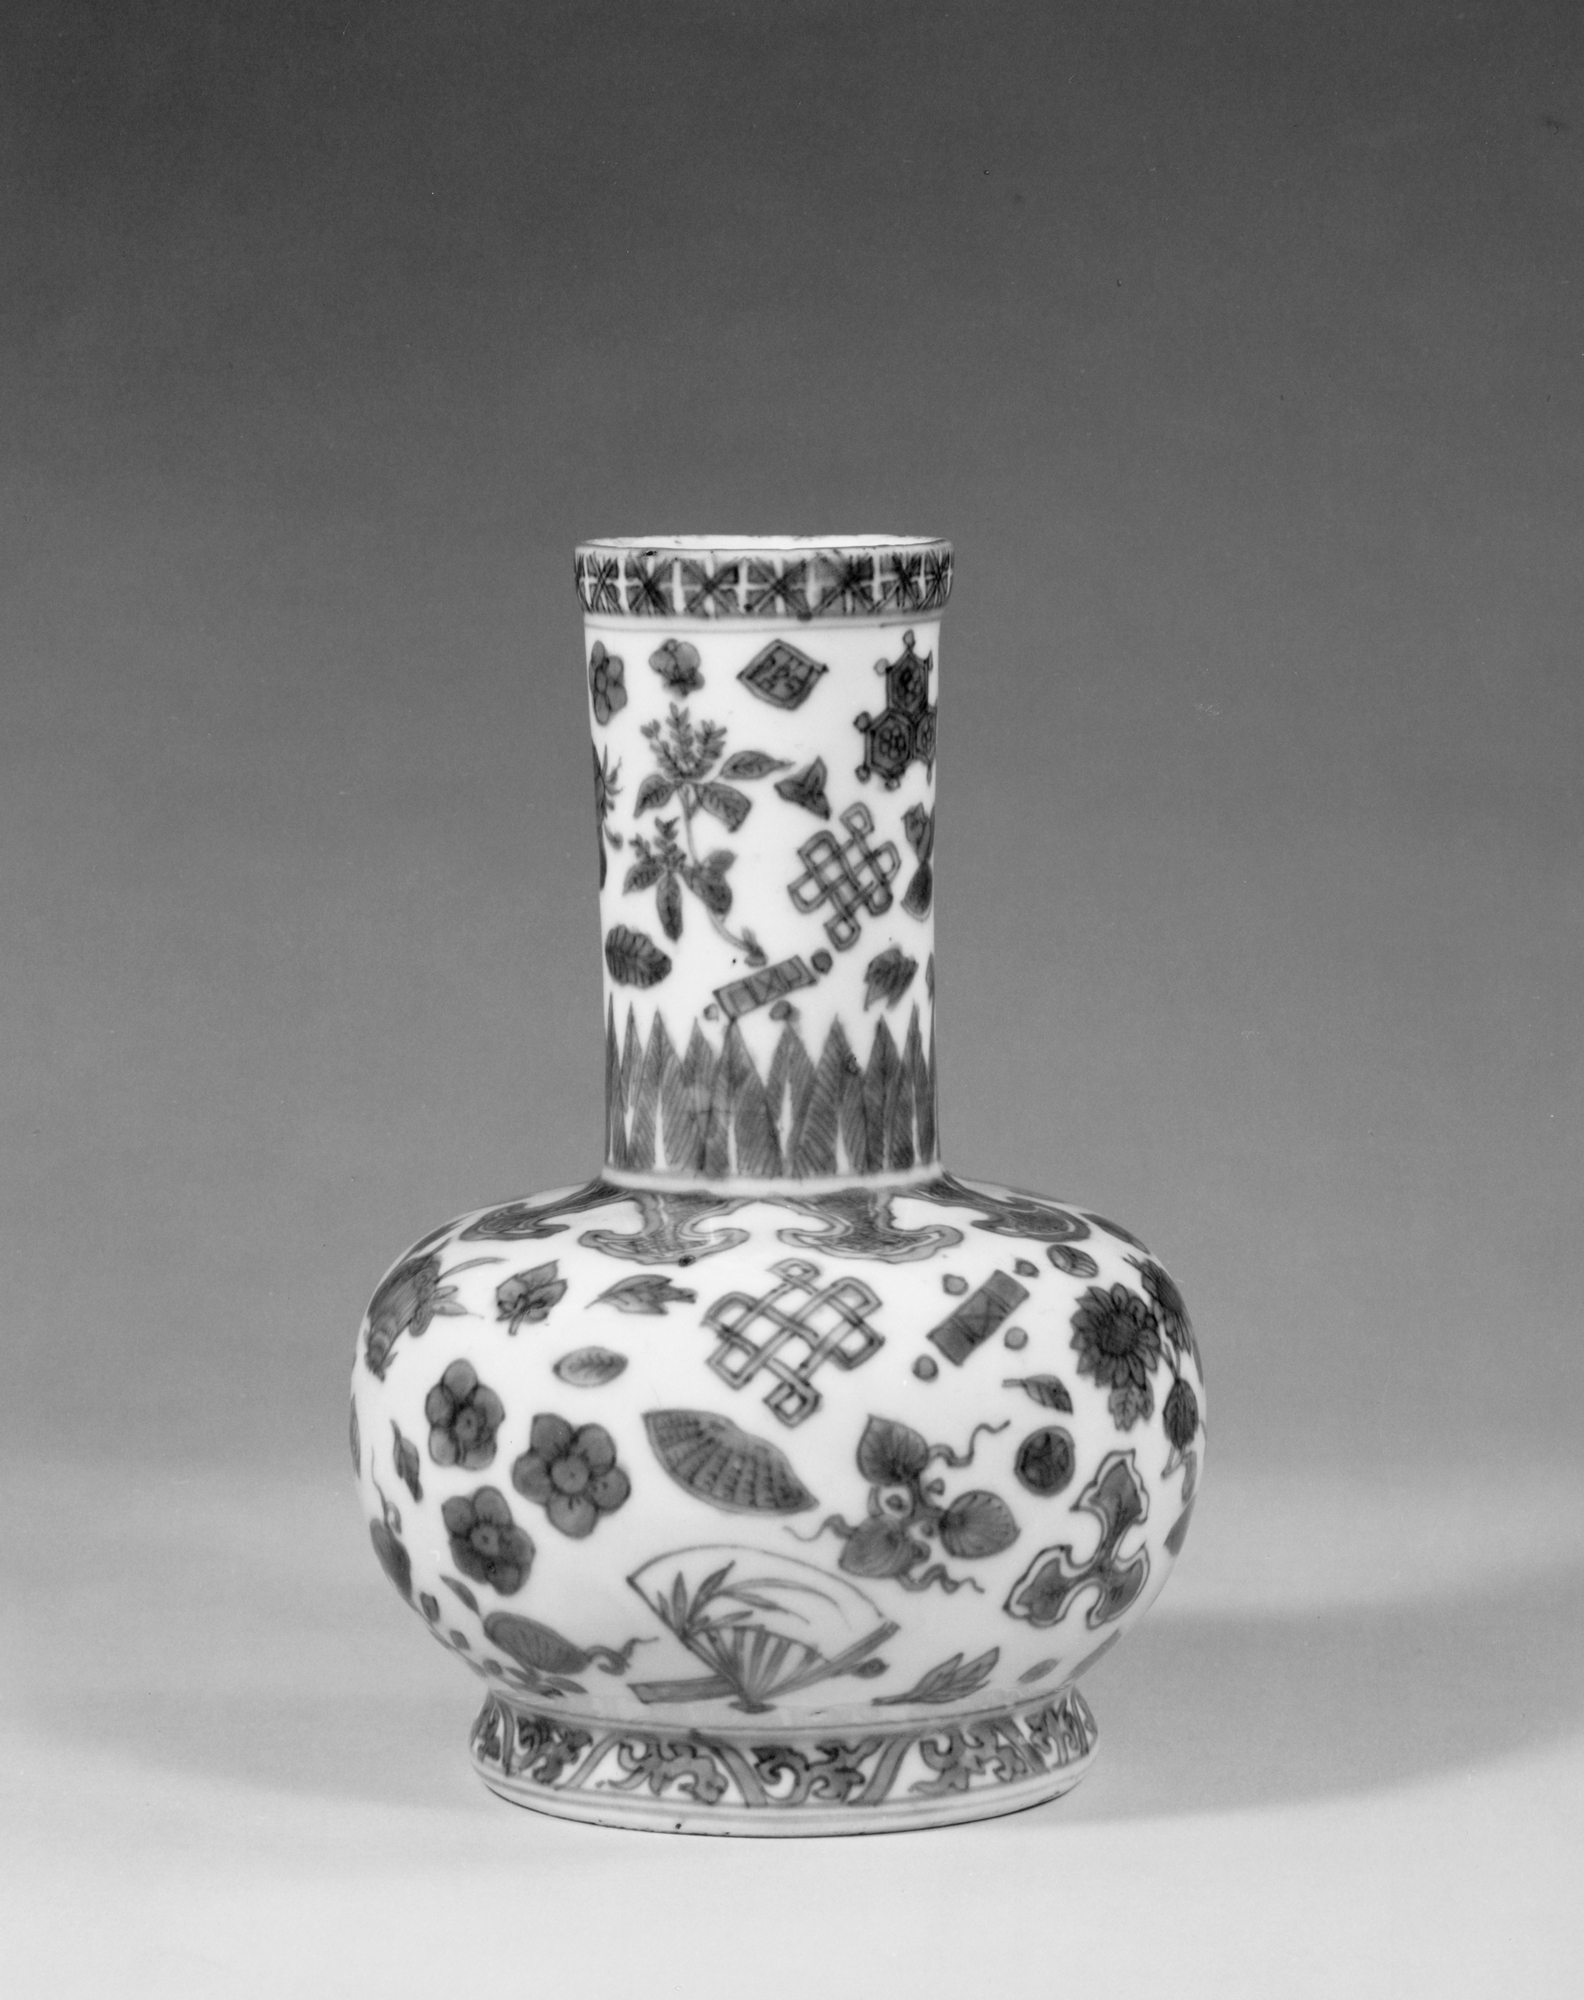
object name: vase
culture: chinese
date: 1645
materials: porcelain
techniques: painting, underglaze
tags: fans,flowers